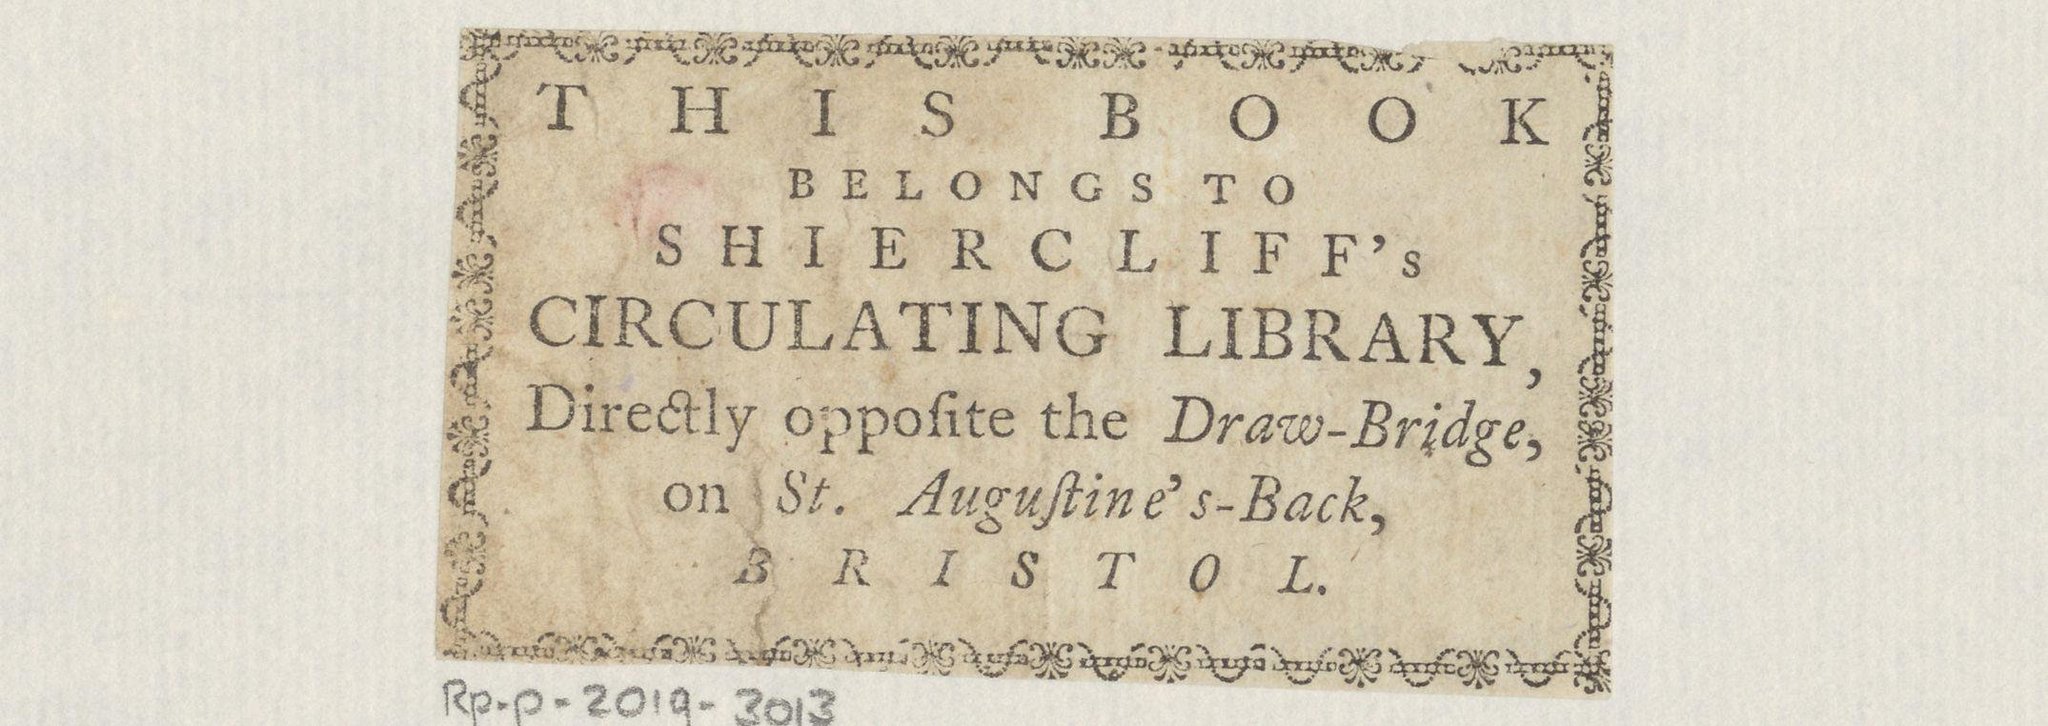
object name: bookplate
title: Ex libris van Shiercliff's Circulating Library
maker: Anonymous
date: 1750-1899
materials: paper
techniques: letterpress printing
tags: library